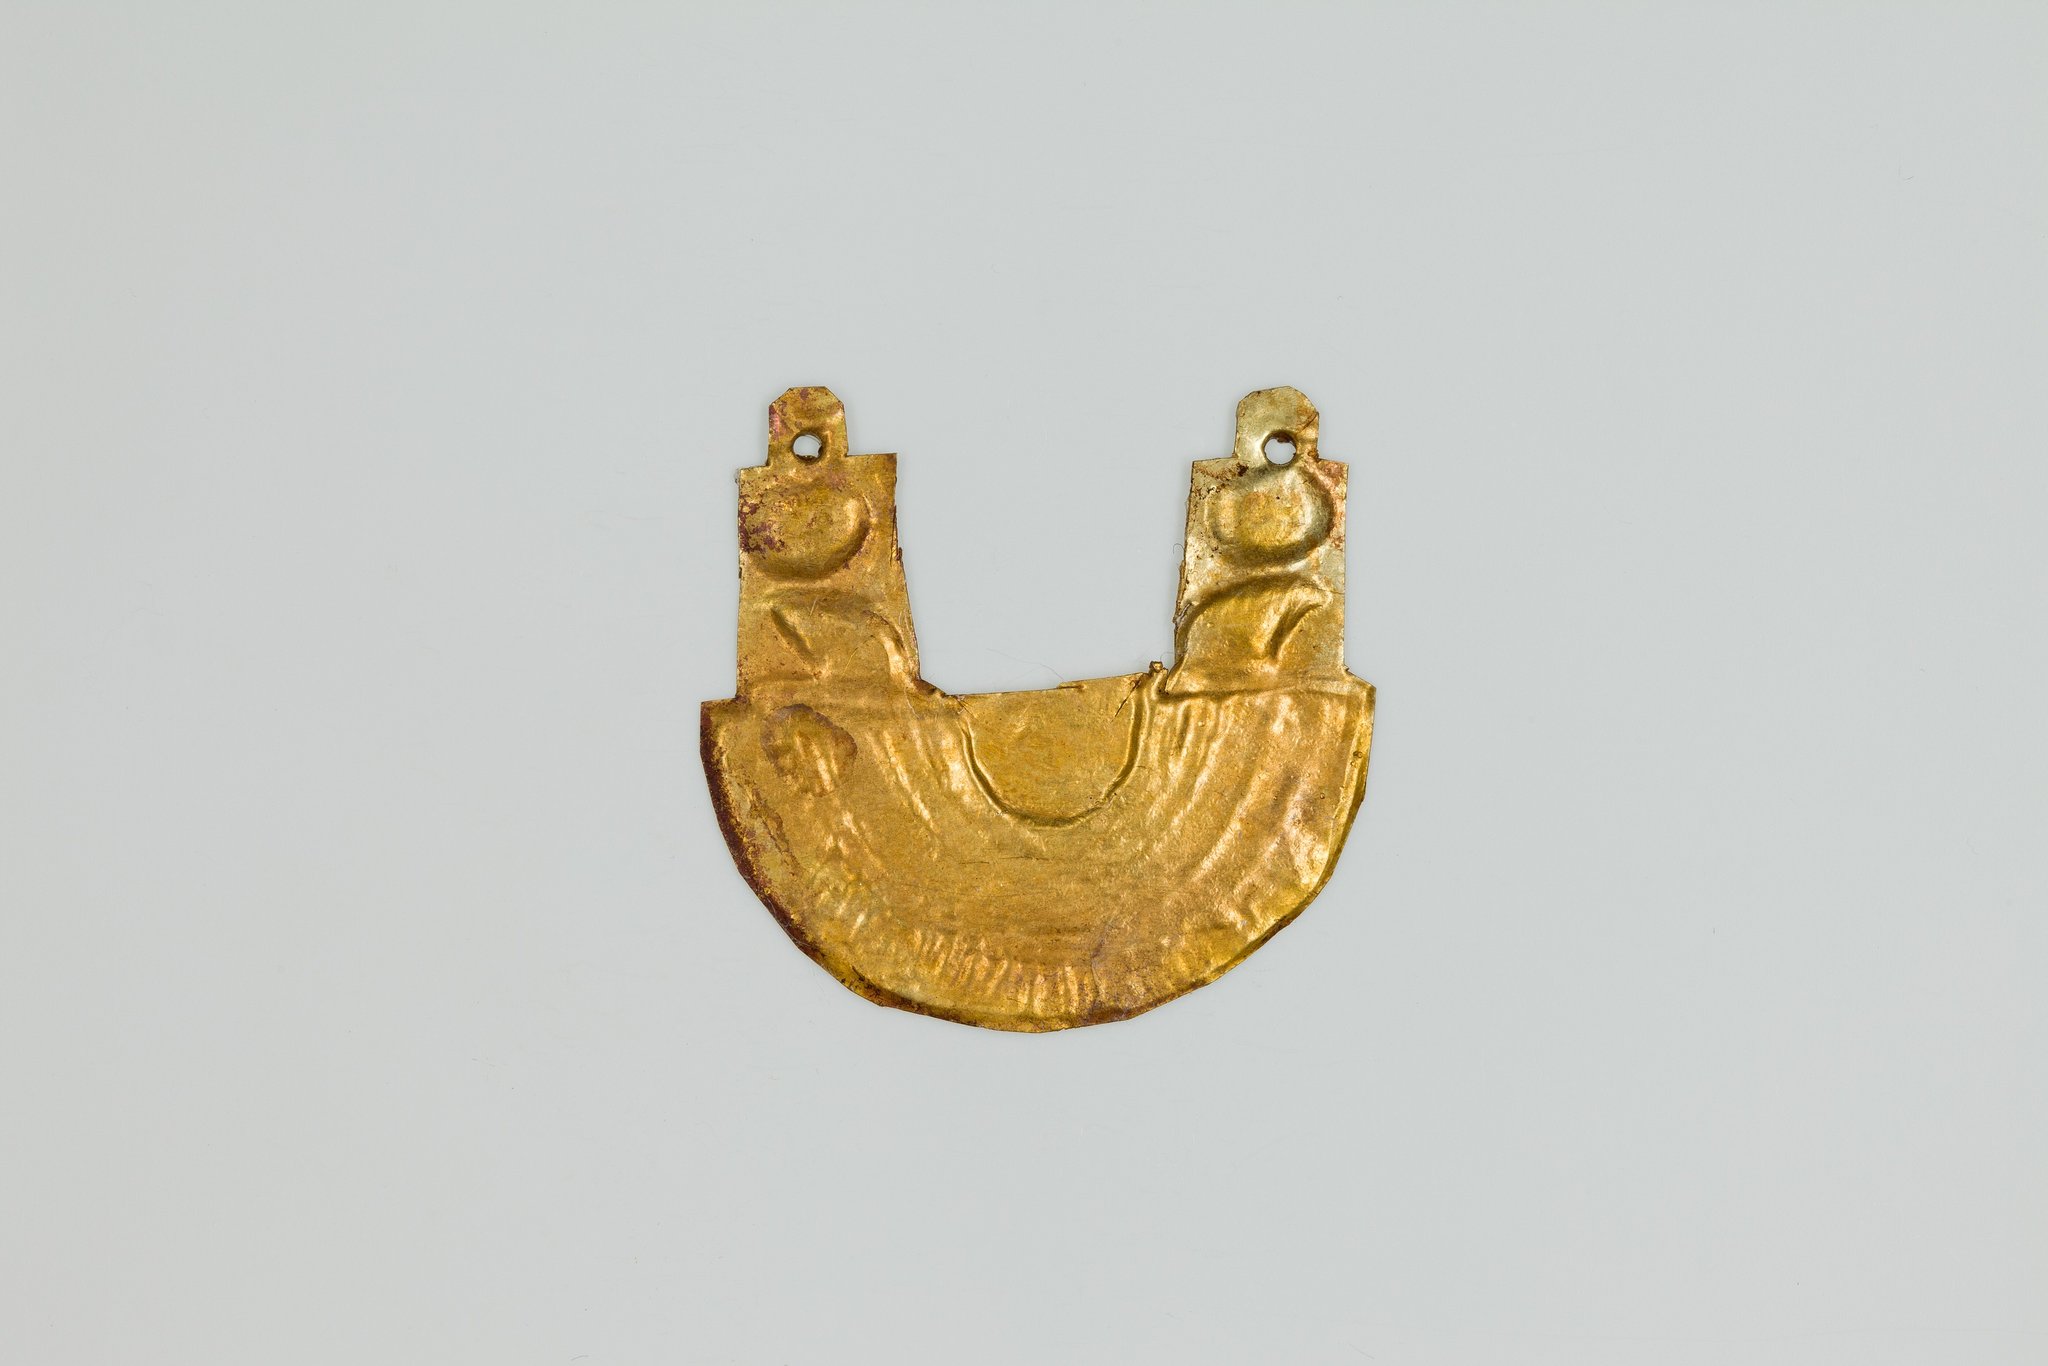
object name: amulet, falcon headed collar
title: Falcon-headed collar amulet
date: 664-380 BCE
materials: gold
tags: falcons